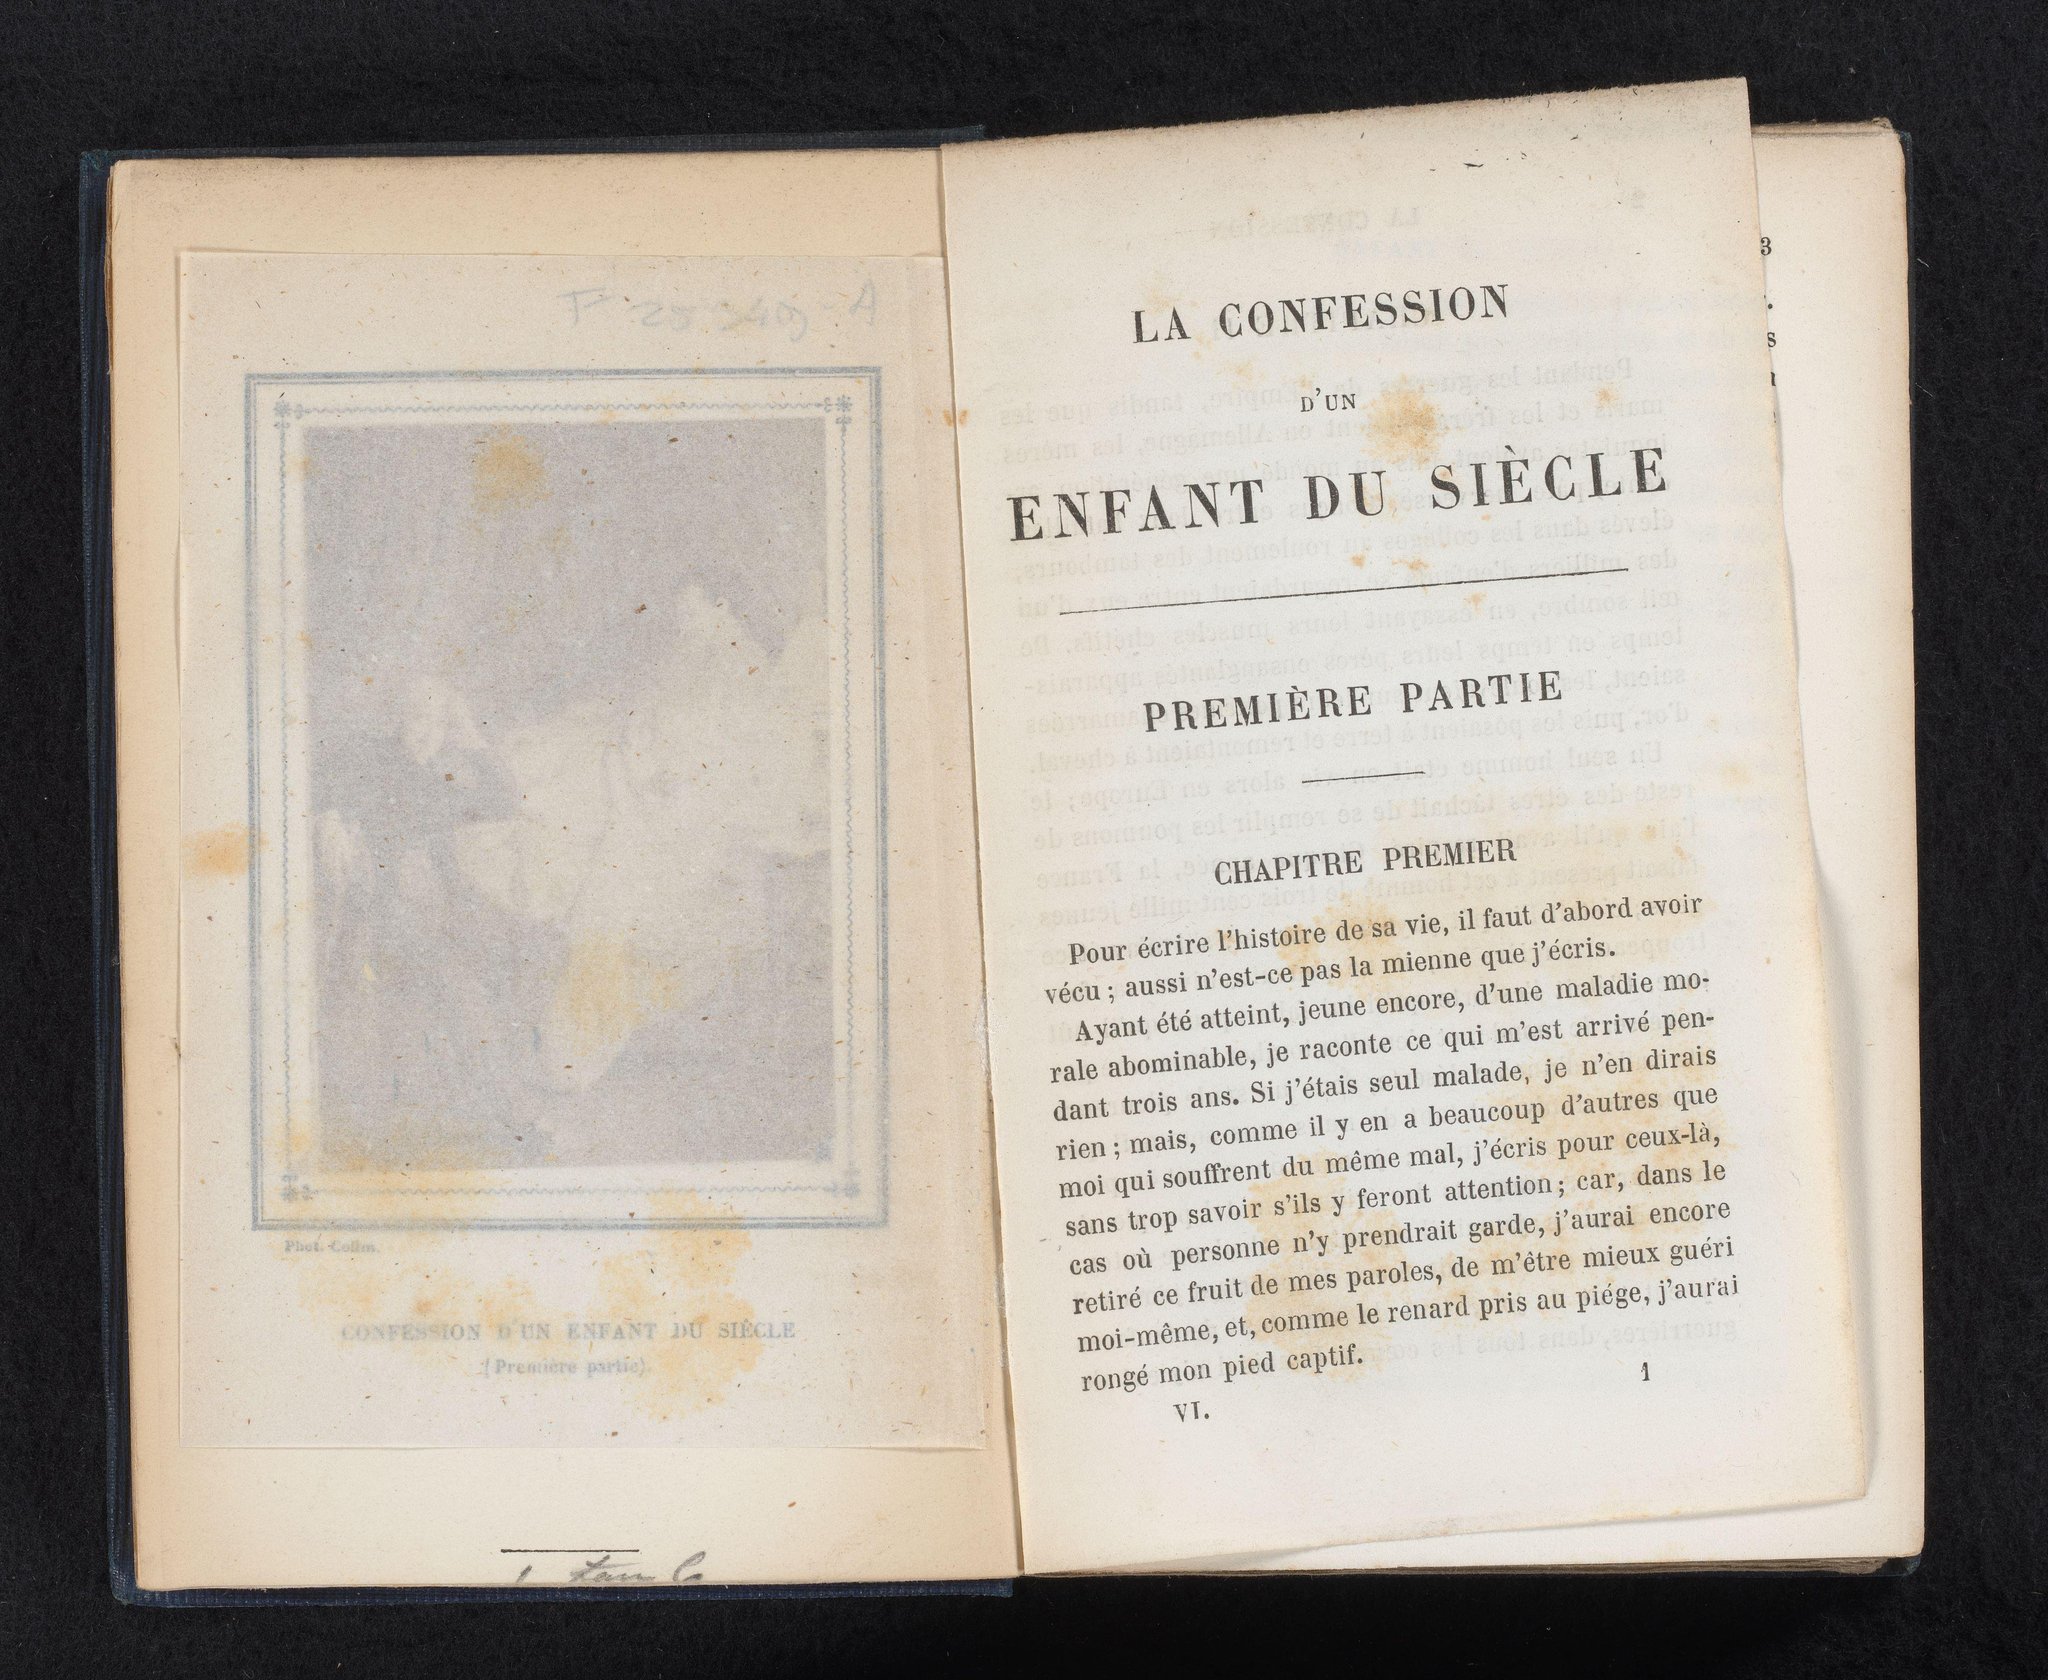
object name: book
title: La confession d'un enfant du siècle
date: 1867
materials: cardboard, paper, linen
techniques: albumen print, letterpress printing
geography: paris